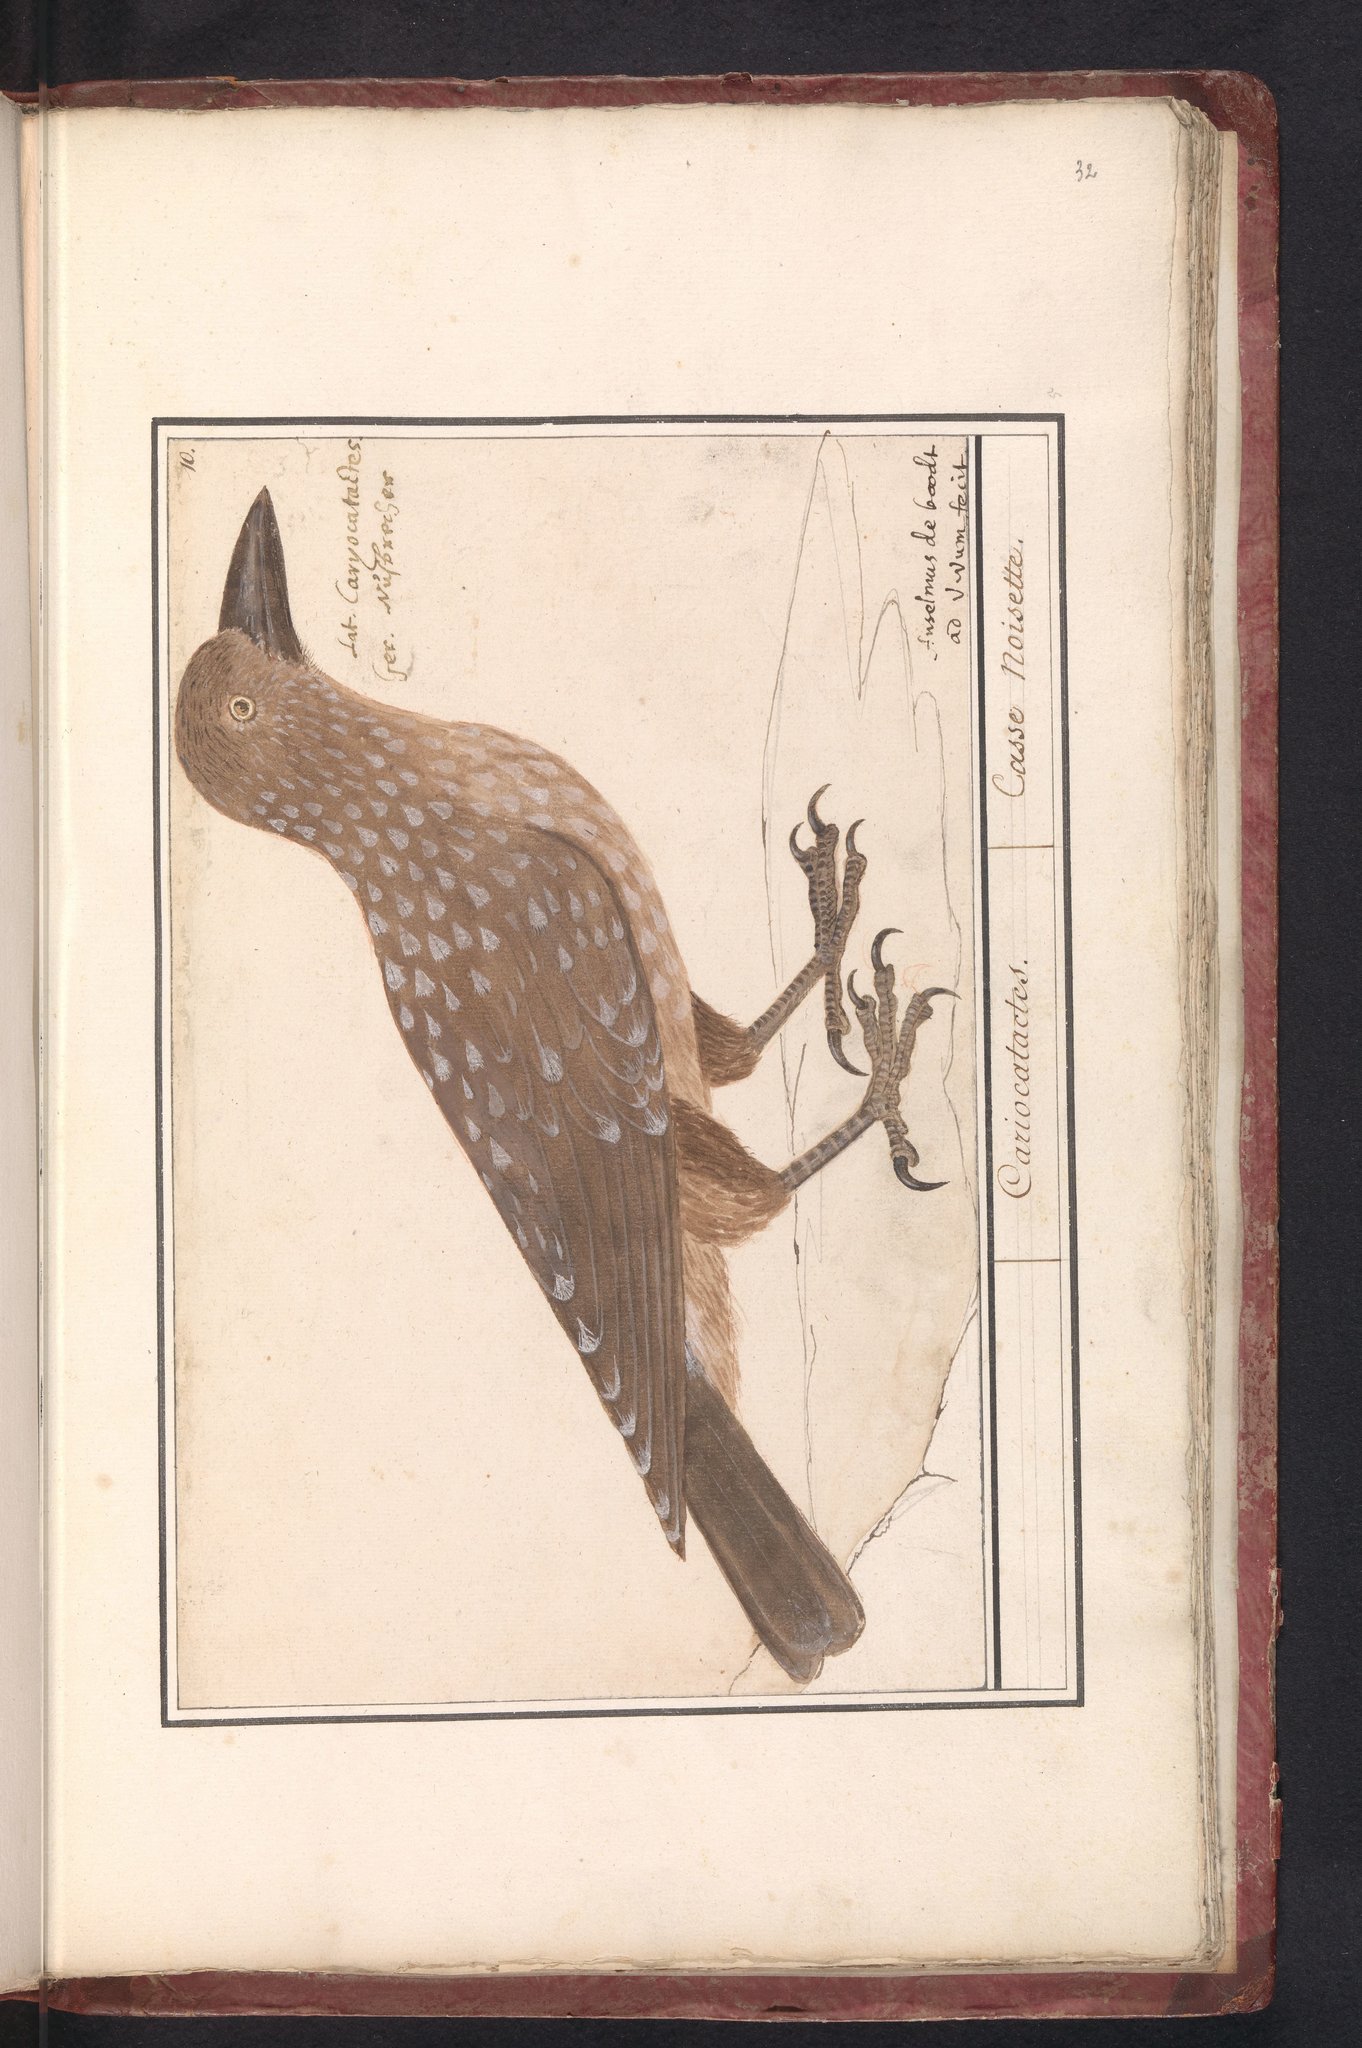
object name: drawing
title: Spotted Nutcracker (Nucifraga caryocatactes)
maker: anselmus boëtius de boodt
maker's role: draughtsman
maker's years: 1550-1632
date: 1596-1610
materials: paint, ink, paper, pencil, watercolor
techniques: brush, pen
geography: prague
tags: song-birds: spotted nutcracker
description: De Boodt could study many living animals from distant places in Rudolf II’s menagerie (zoo). He could have seen mounted specimens in Rudolf’s Kunstkammer. Yet some animals were ‘borrowed’ from illustrations by other artists. Could De Boodt have been looking at a live or stuffed specimen? Or did he copy it? In any case, the dark brown plumage and the beautiful ‘white drops’ are convincingly rendered.